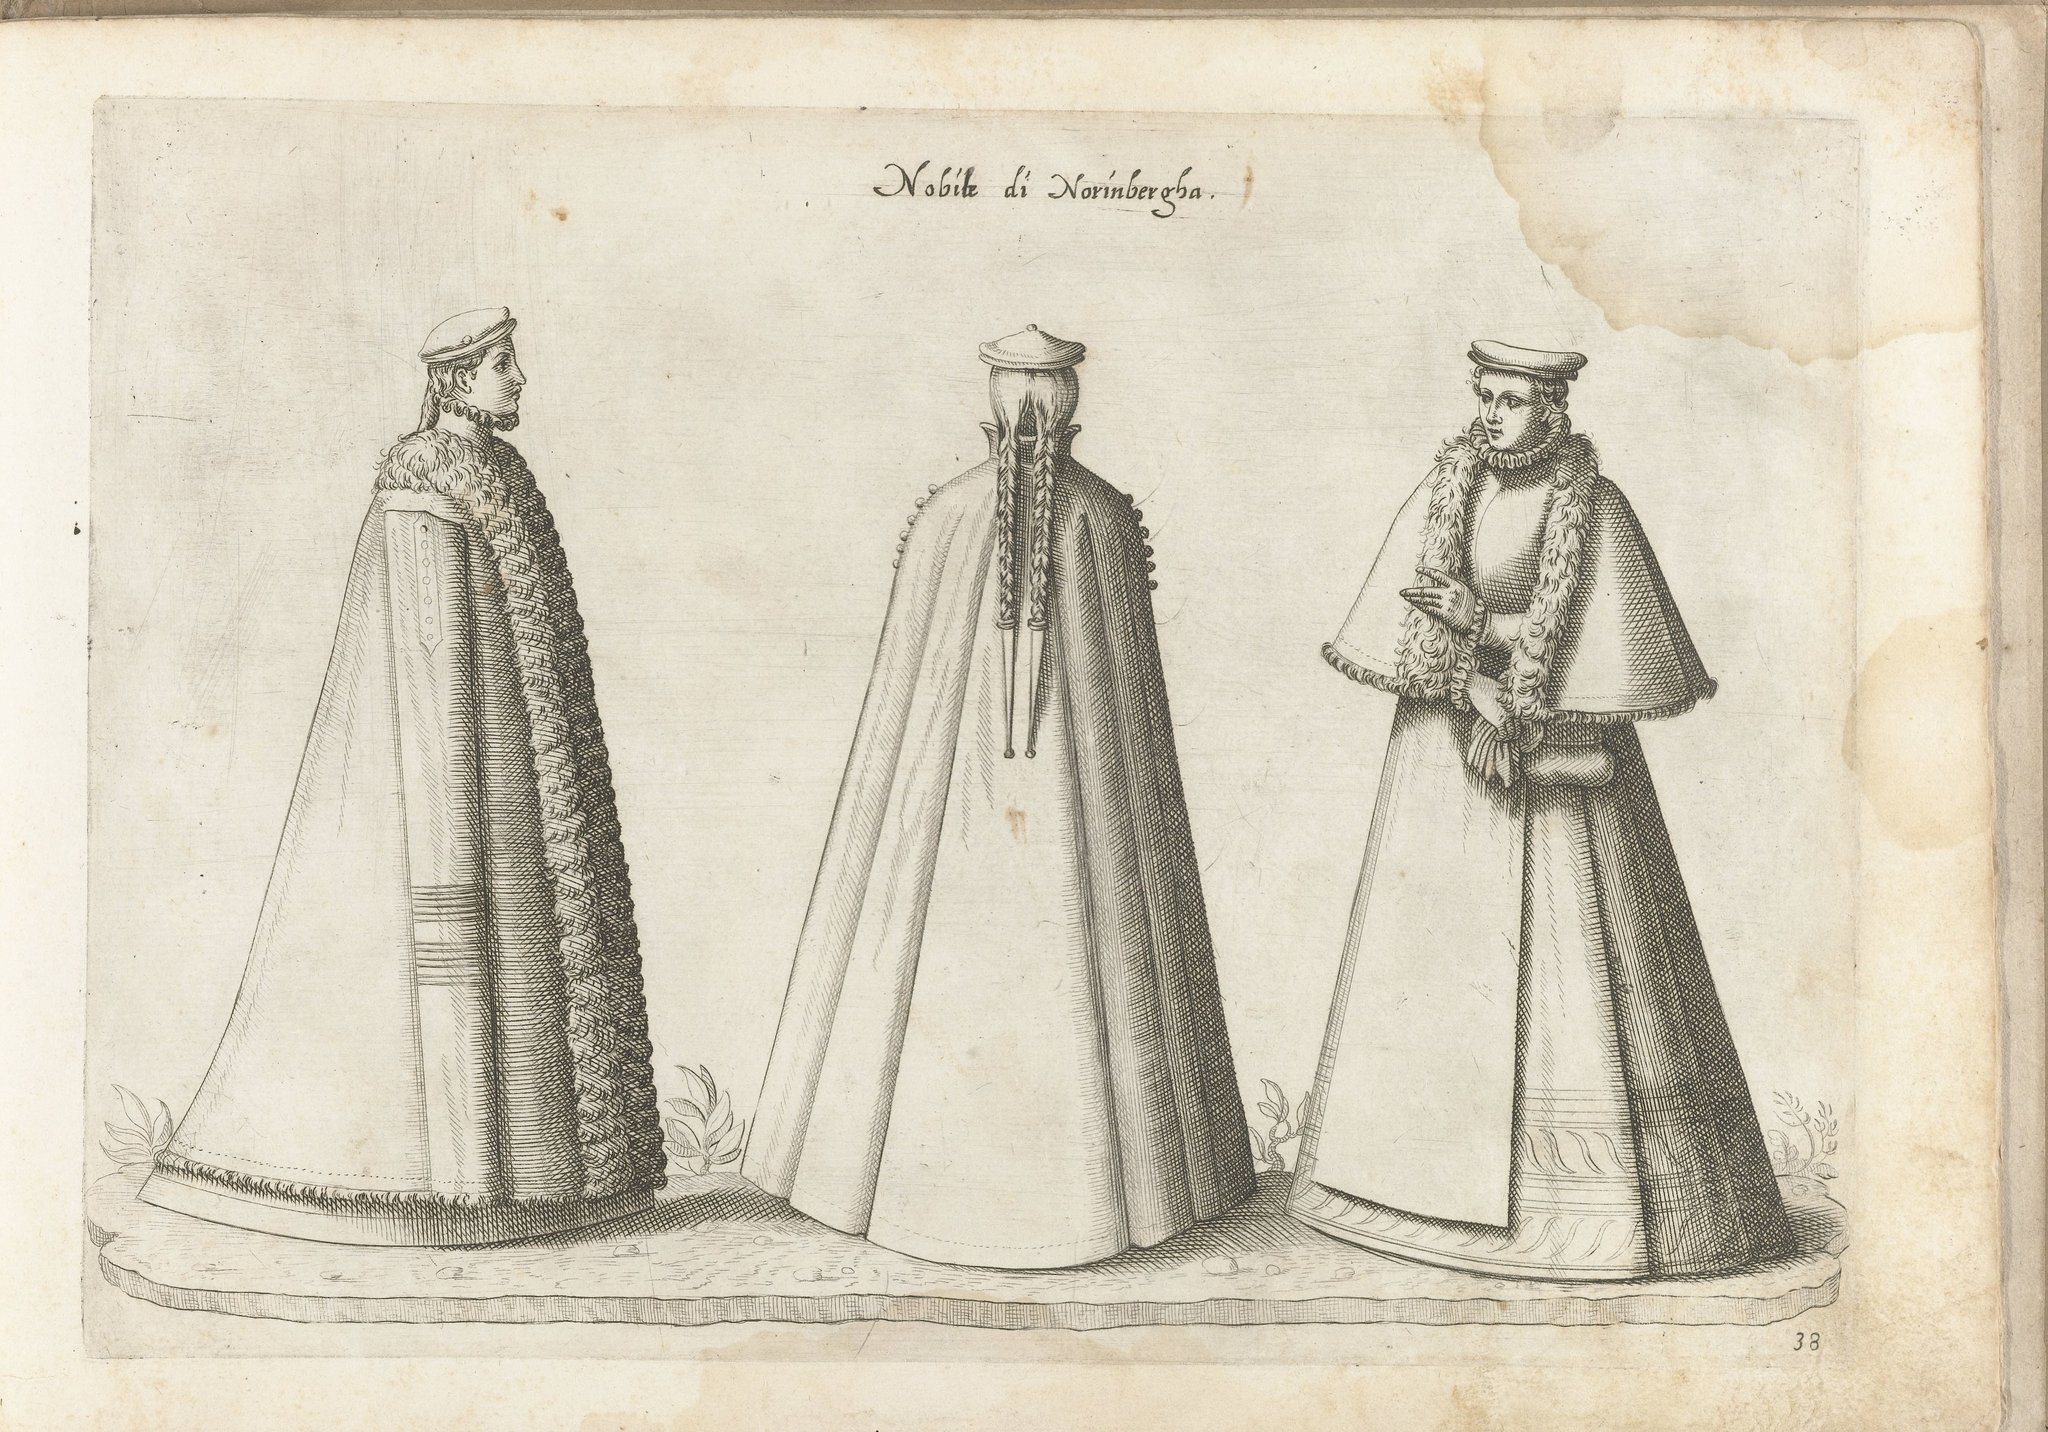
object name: costume print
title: Drie vrouwen, gekleed volgens de mode in Neurenberg van ca. 1580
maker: bartolomeo grassi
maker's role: publisher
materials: paper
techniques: engraving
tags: coat (+ fur used for clothes), coat (+ women's clothes), cape (+ women's clothes), styles of hairdress (with name) - aa - ~ women, clothing for the upper part of the body (cape) (+ women's clothes), europeans: germans (+ costume), germany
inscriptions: number: ‘37’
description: De middelste vrouw, met lange vlechten, op de rug gezien. Prent uit album 'Dei veri ritratti degl'habiti di tvtte le parti del mondo intagliati in rame per opra di Bartolomeo Grassi', 1585.